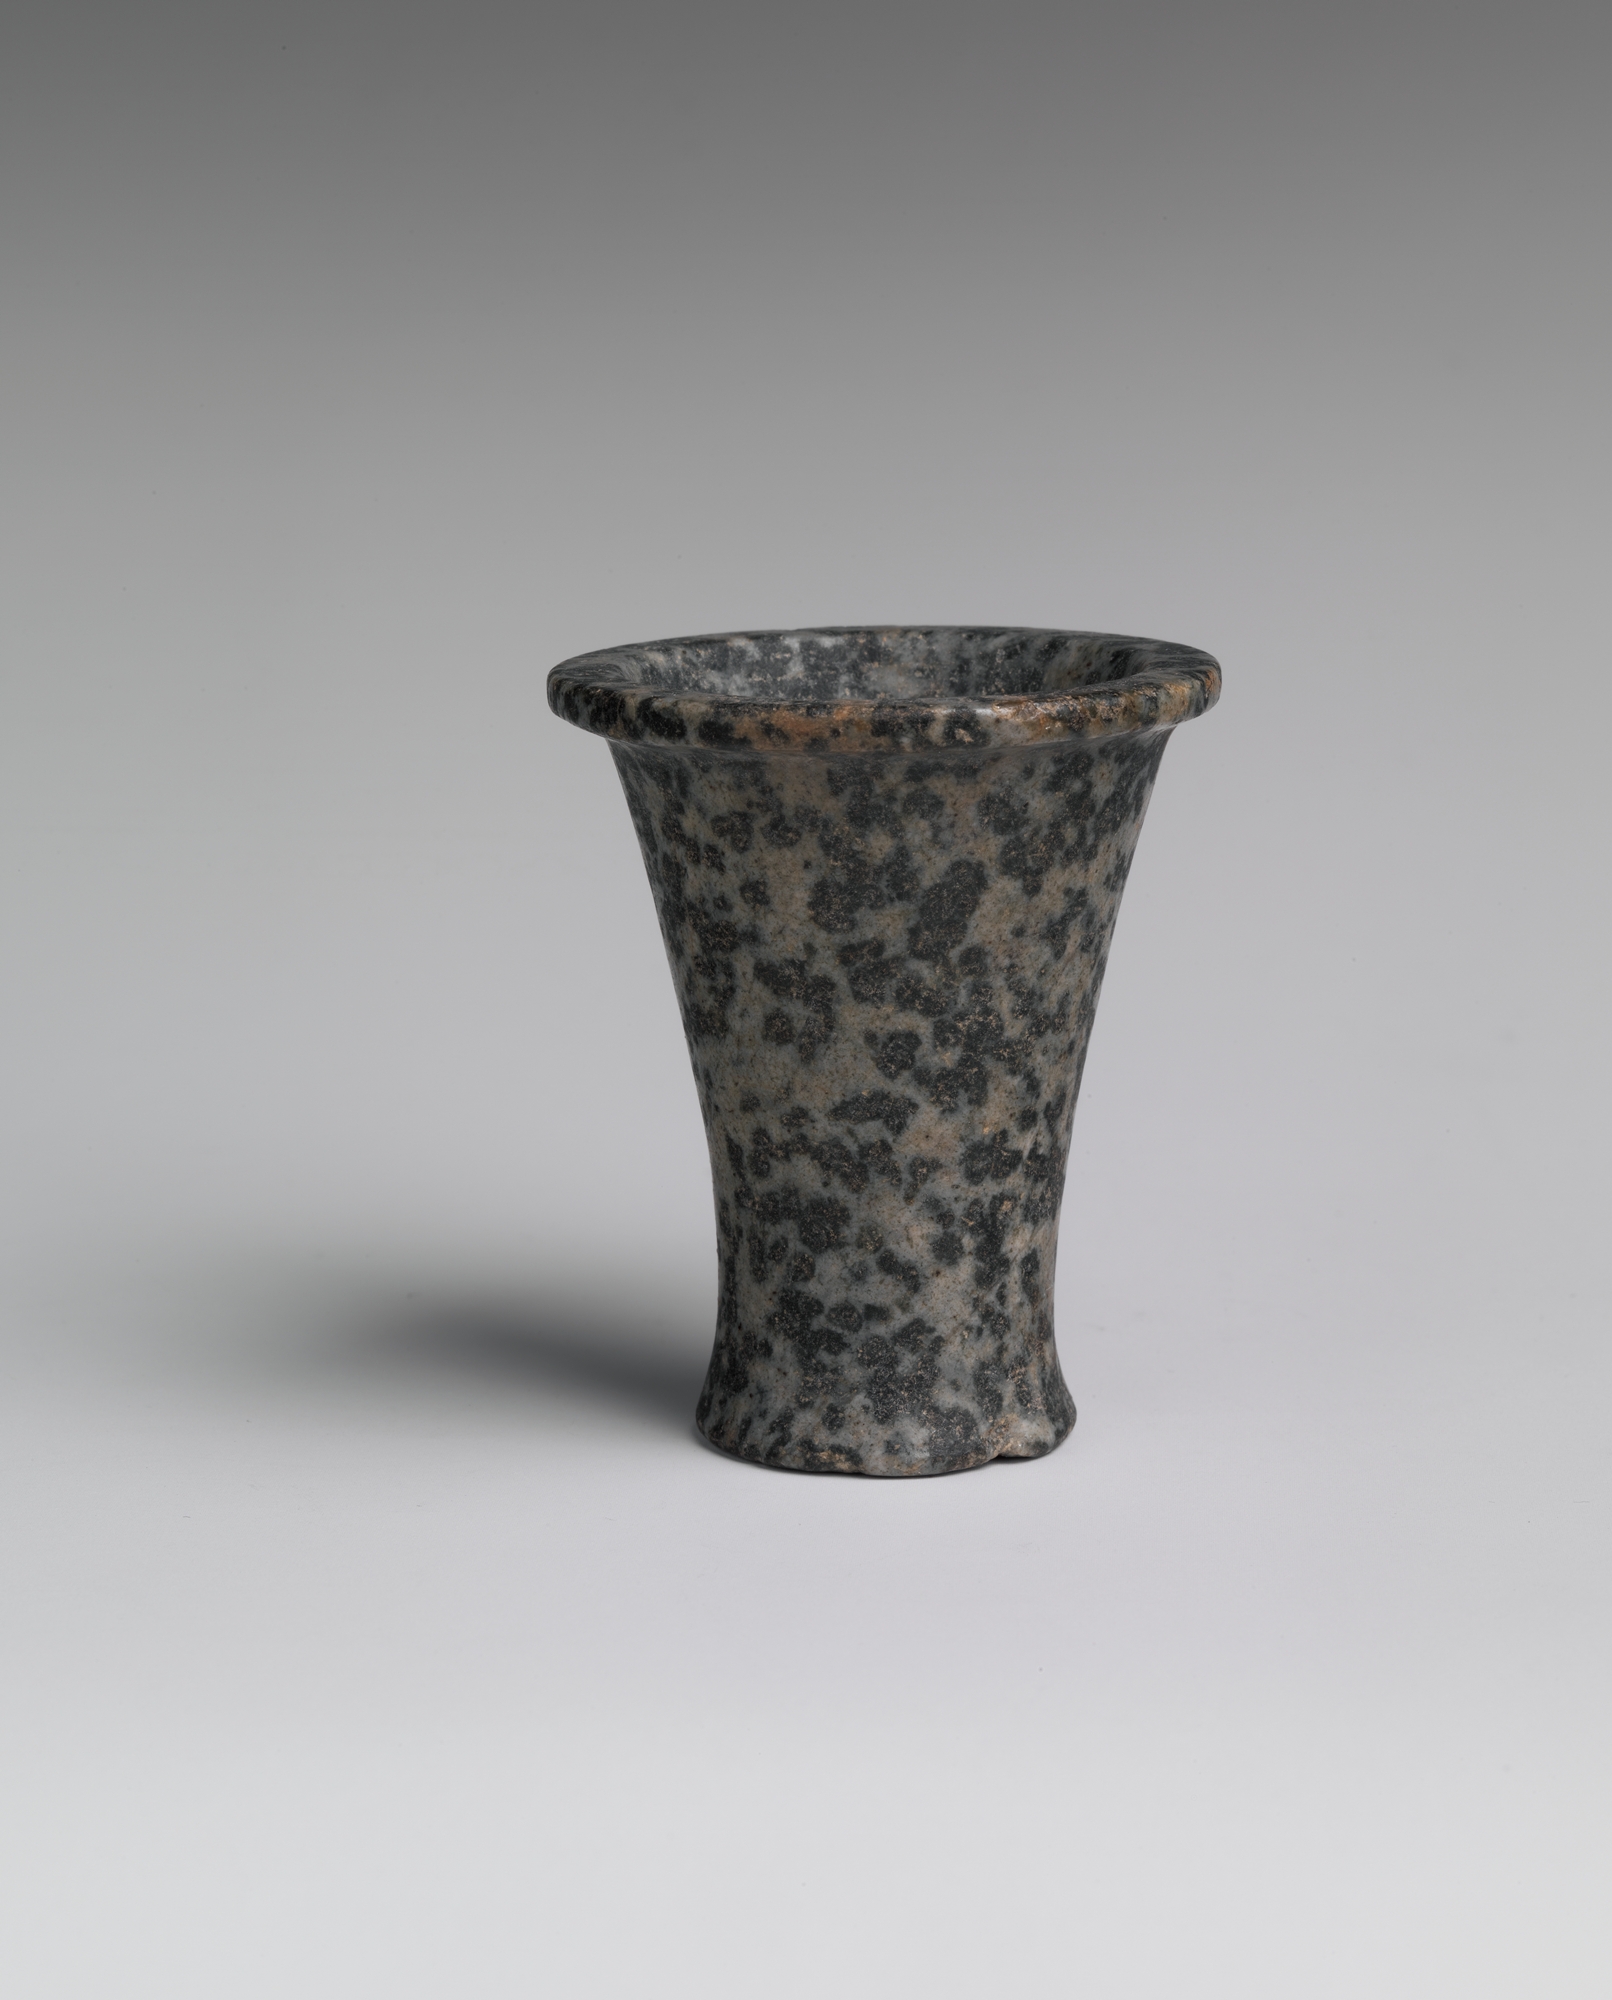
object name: jar, stone, flaring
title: Ointment Jar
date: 1550-1450 BCE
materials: stone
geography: egypt